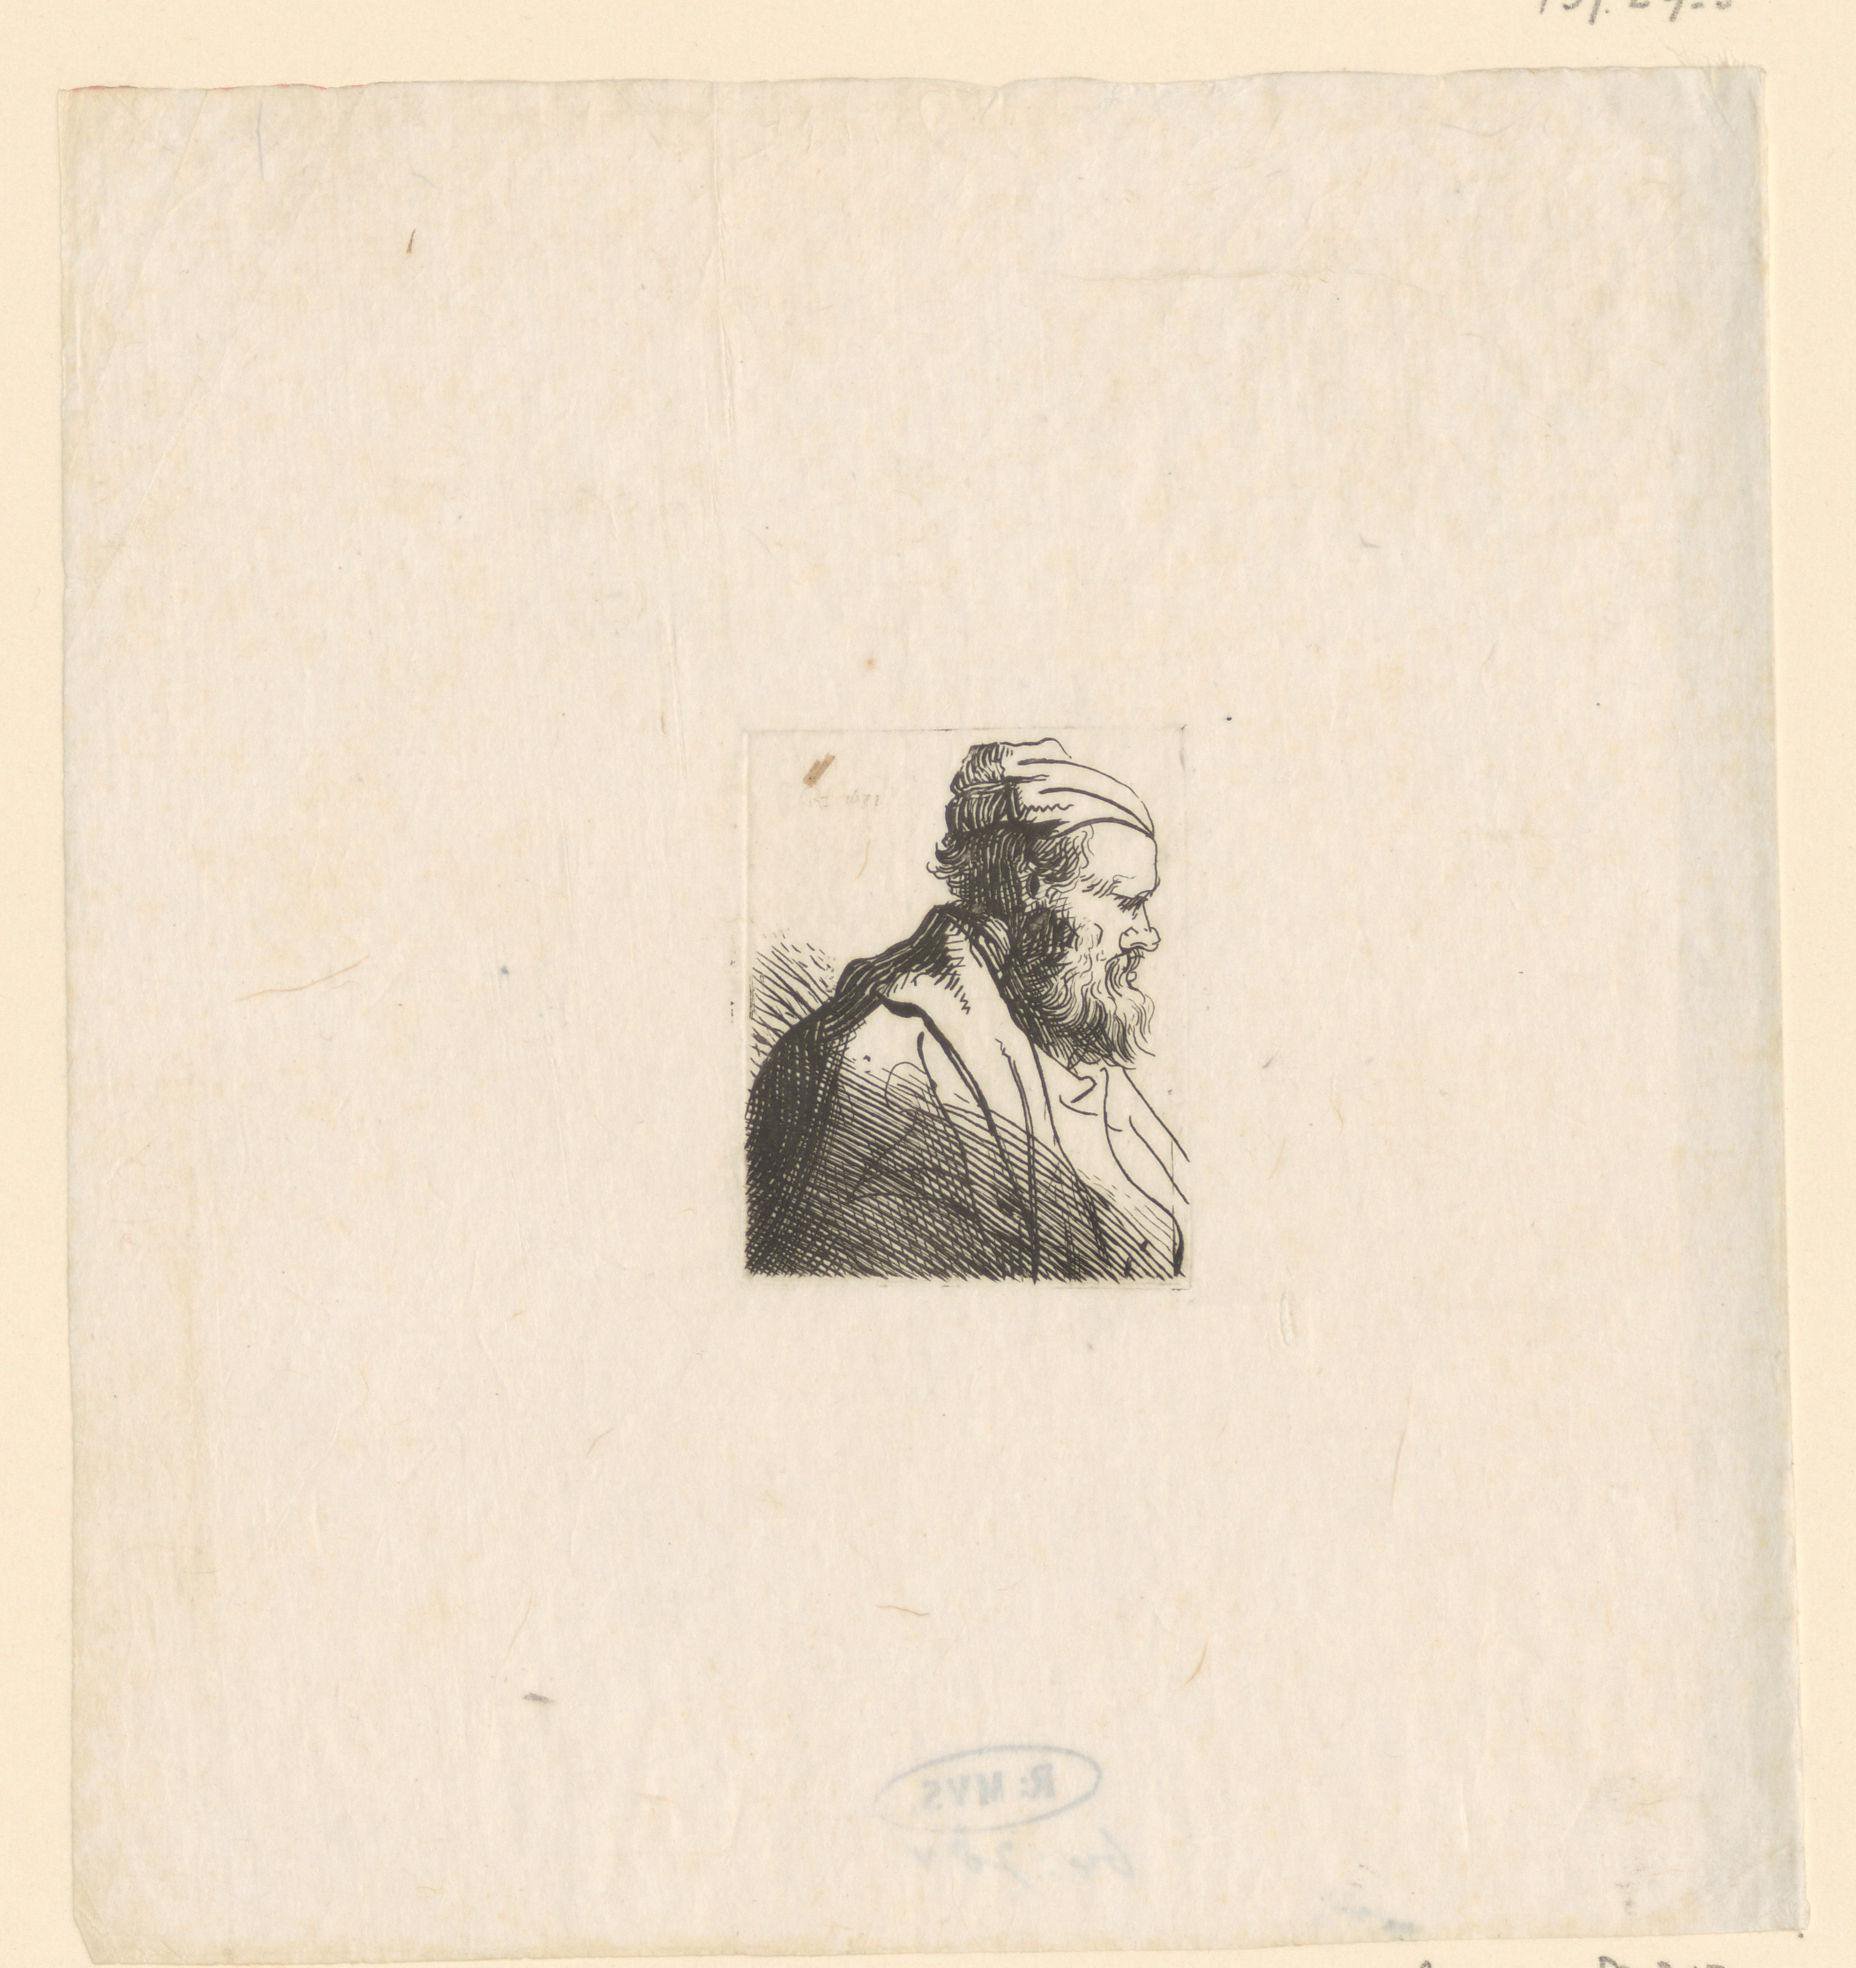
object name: print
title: Twelve Facsimile Etchings from very rare Originals by Rembrandt van Ryn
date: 1824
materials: paper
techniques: etching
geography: london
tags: head (human) (+ sideview, profile), beard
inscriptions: collector's mark: Lugt 2228